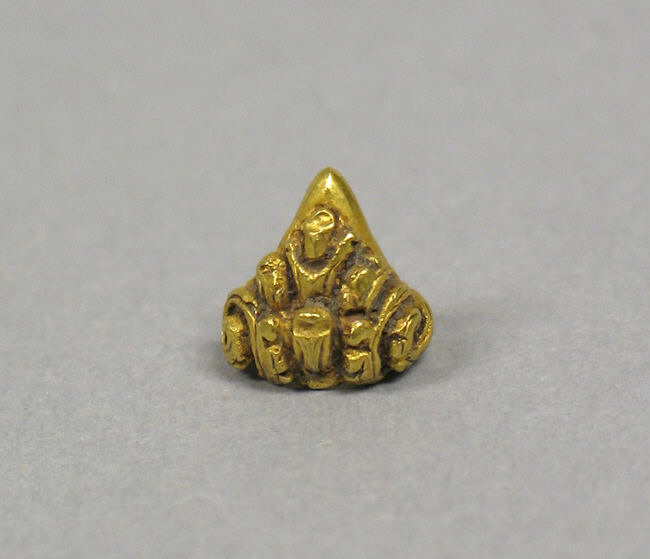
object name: ear ornament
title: Ear Ornament Garuda, Meru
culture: indonesian, central java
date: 701-1200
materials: gold